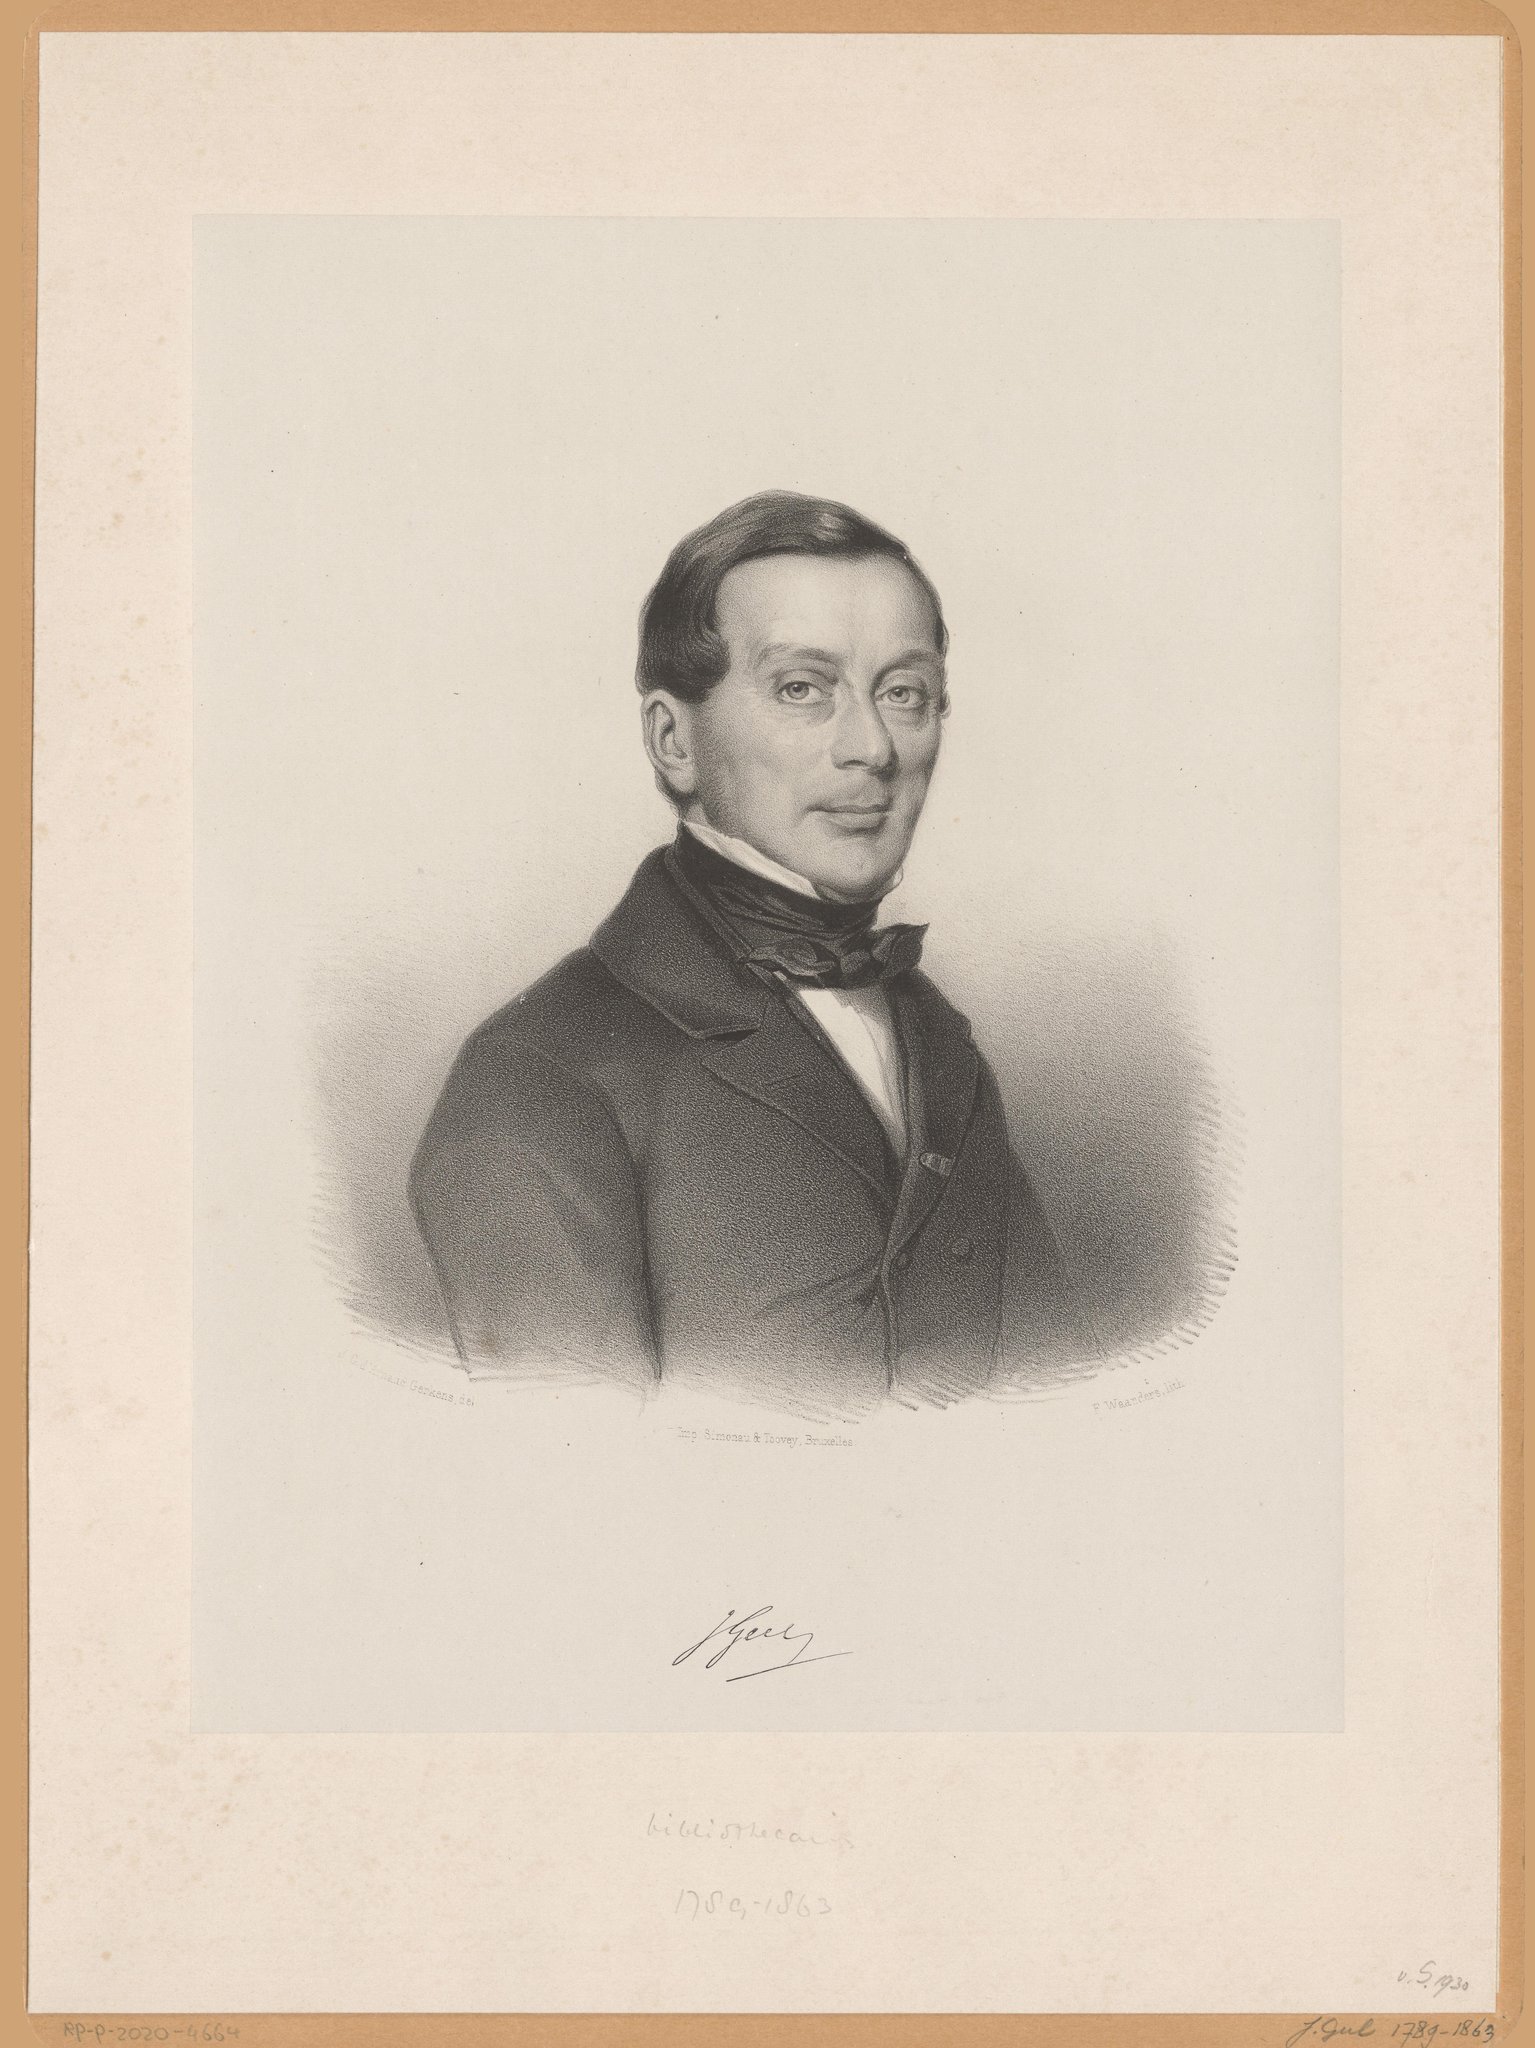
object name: print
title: Portret van Jacob Geel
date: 1847-1875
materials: paper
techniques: lithograph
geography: brussels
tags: amsterdam, historical persons, public library